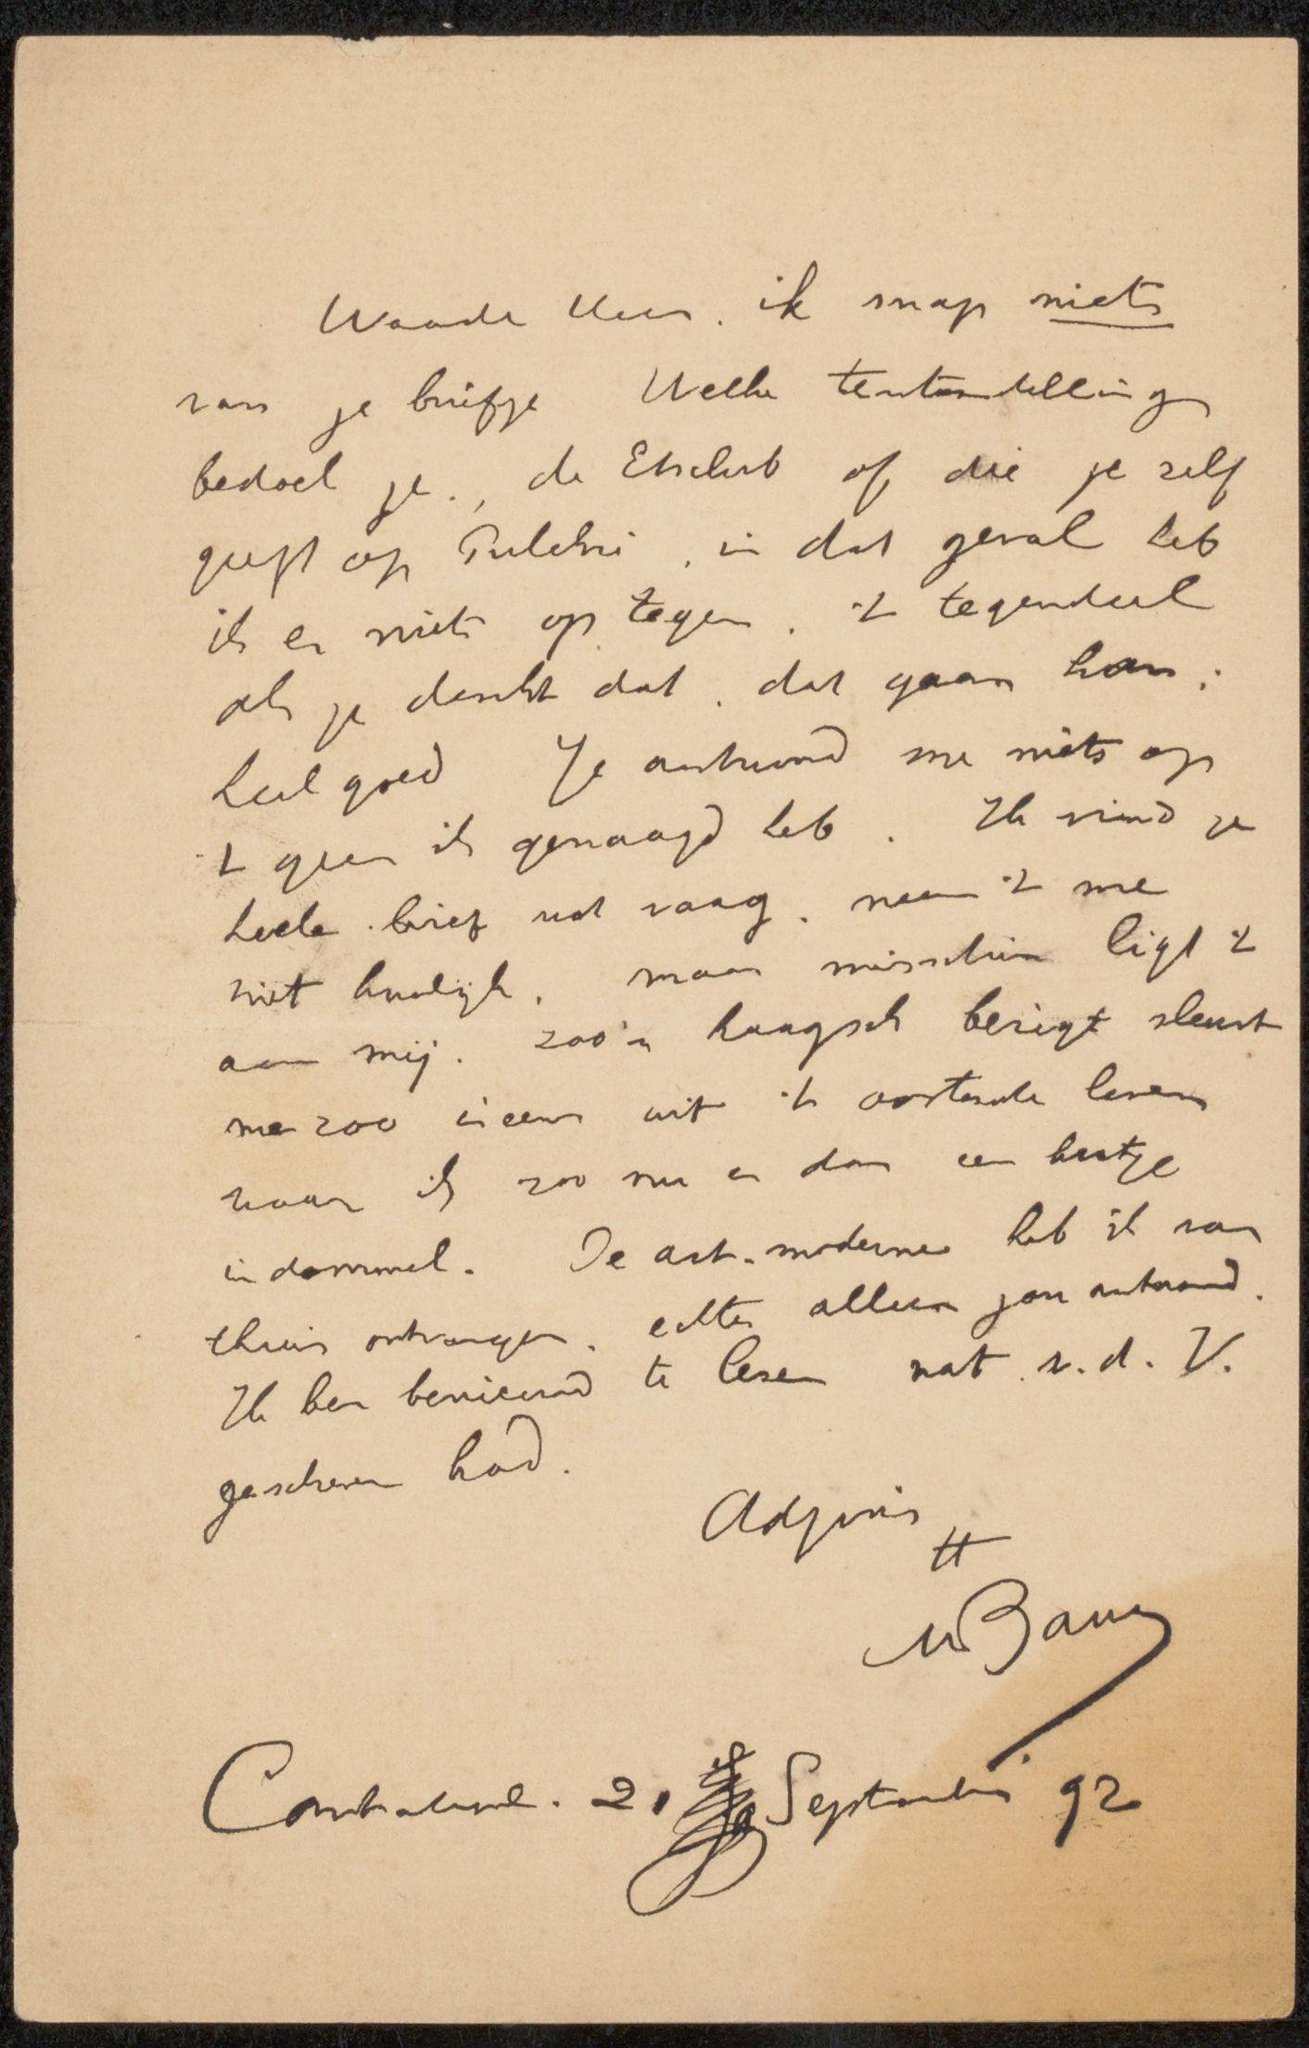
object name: letter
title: Brief aan Philip Zilcken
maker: marius bauer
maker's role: draughtsman, print maker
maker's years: 1867-1932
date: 1892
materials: ink, paper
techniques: pen, writing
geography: constantinople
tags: henri van de velde (1896-1969), the hague, painter, draughtsman, philip zilcken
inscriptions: collector's mark: ‘RPK’